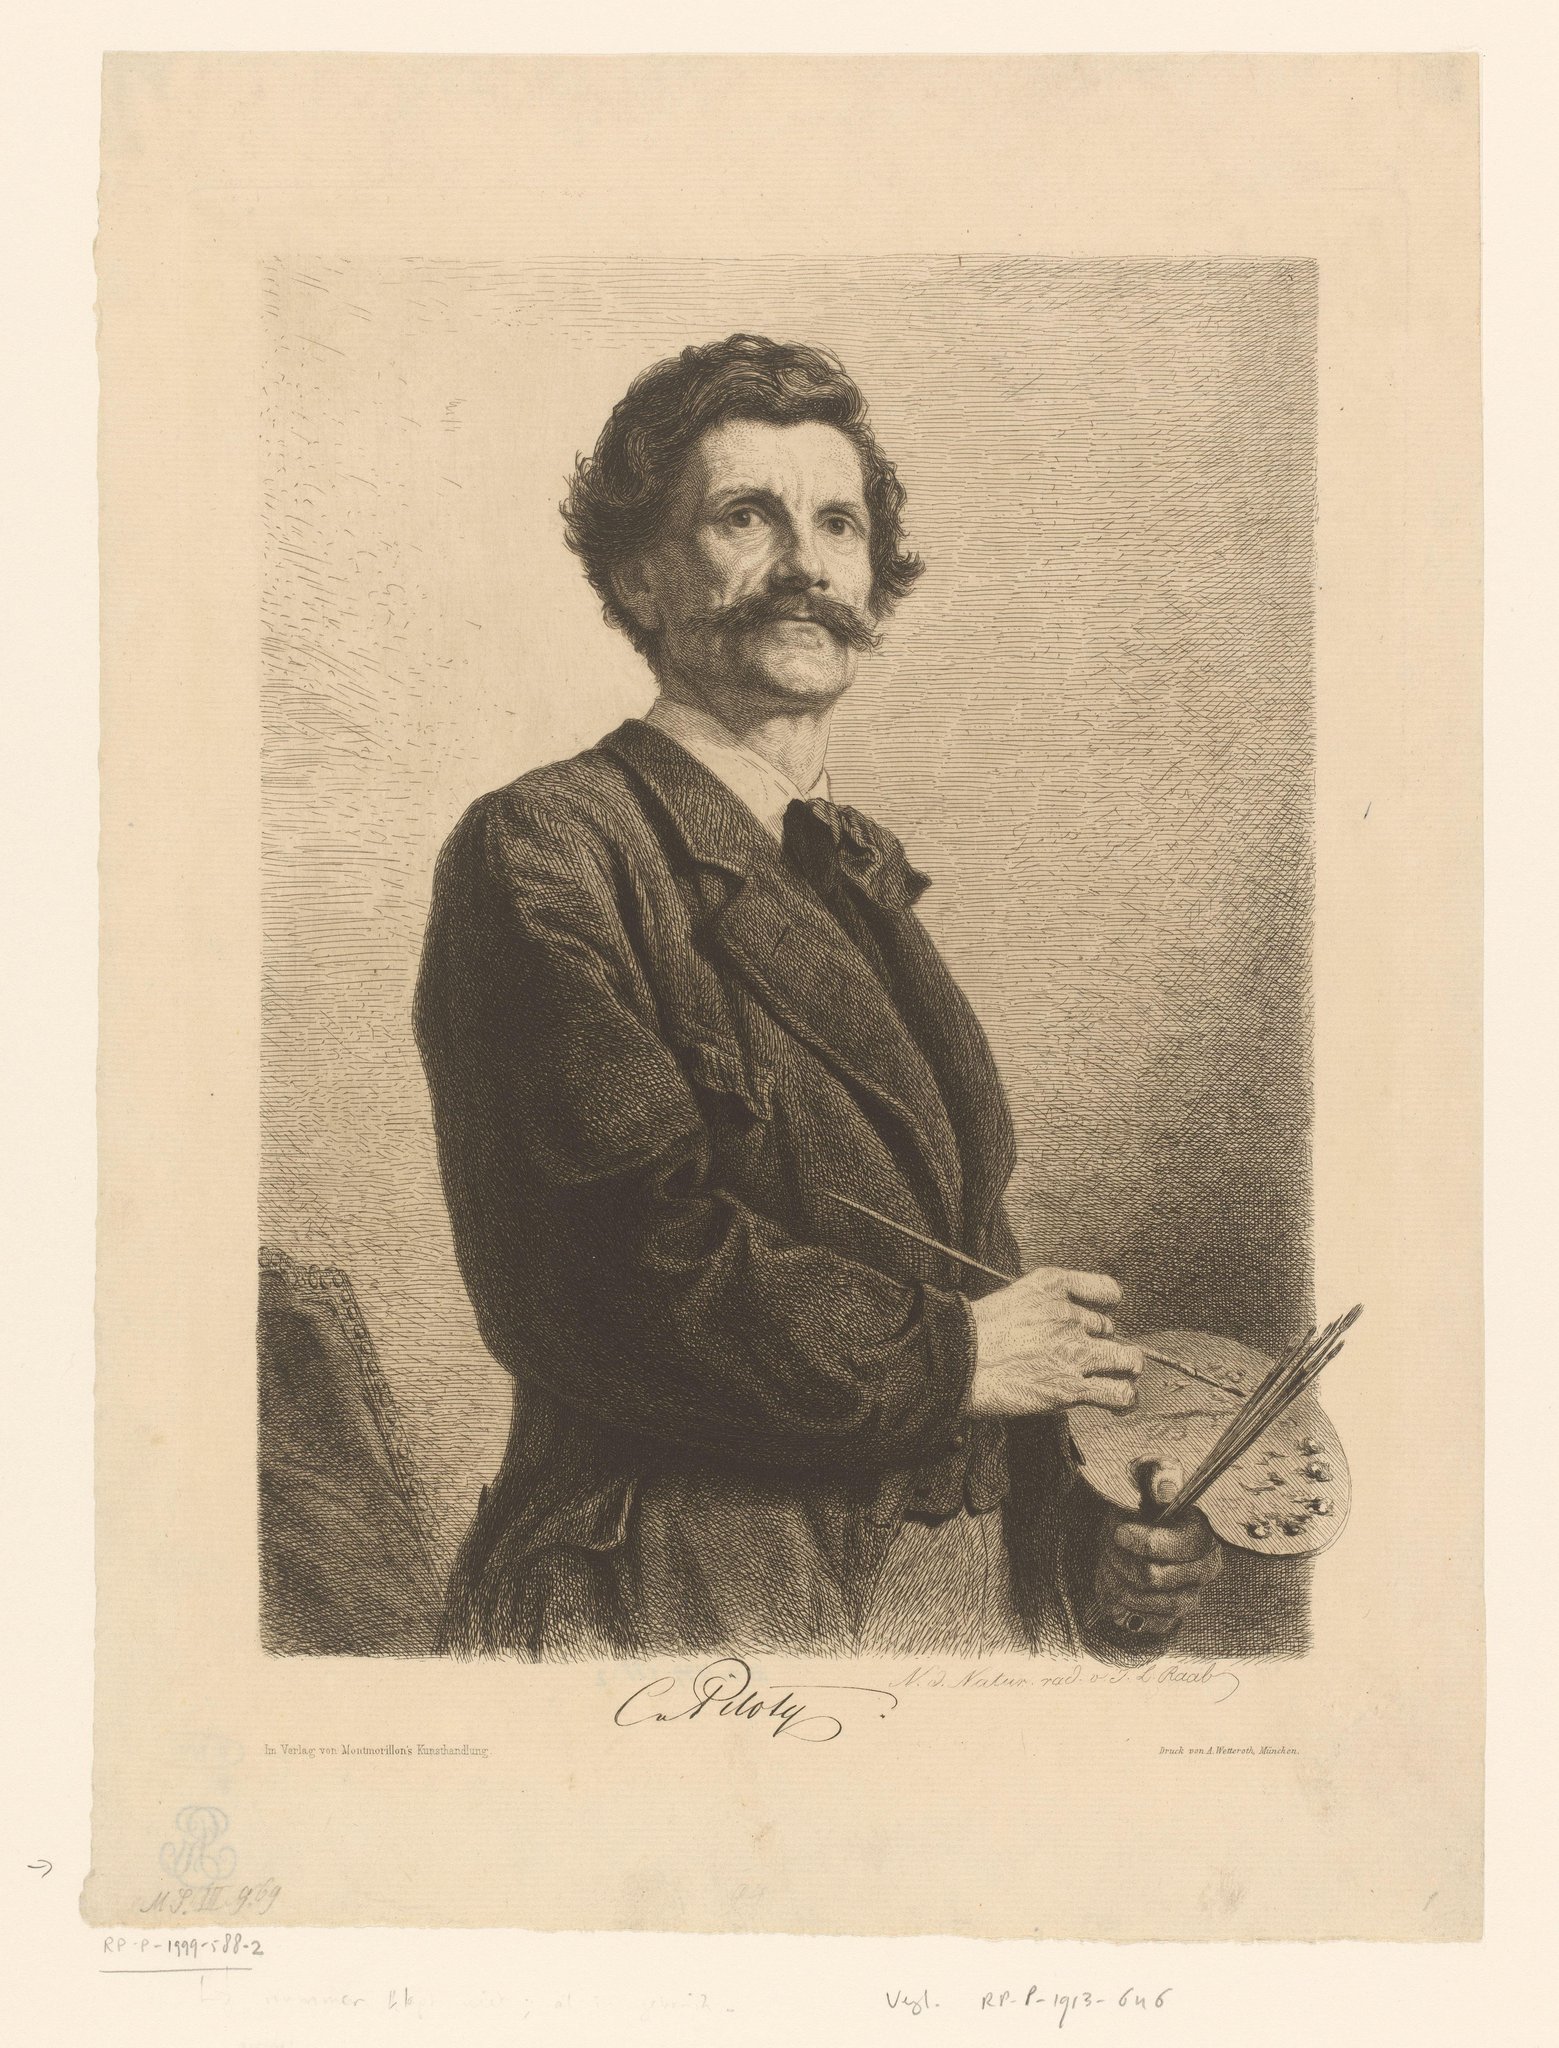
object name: print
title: Portret van Karl Theodor Piloty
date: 1866-1899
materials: paper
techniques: etching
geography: munich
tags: painter, draughtsman, karl theodor piloty, historical persons, portrait, self-portrait of painter, palette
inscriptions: collector's mark: Lugt 2760, collector's mark: Lugt 2228, collector's mark: Lugt 4100